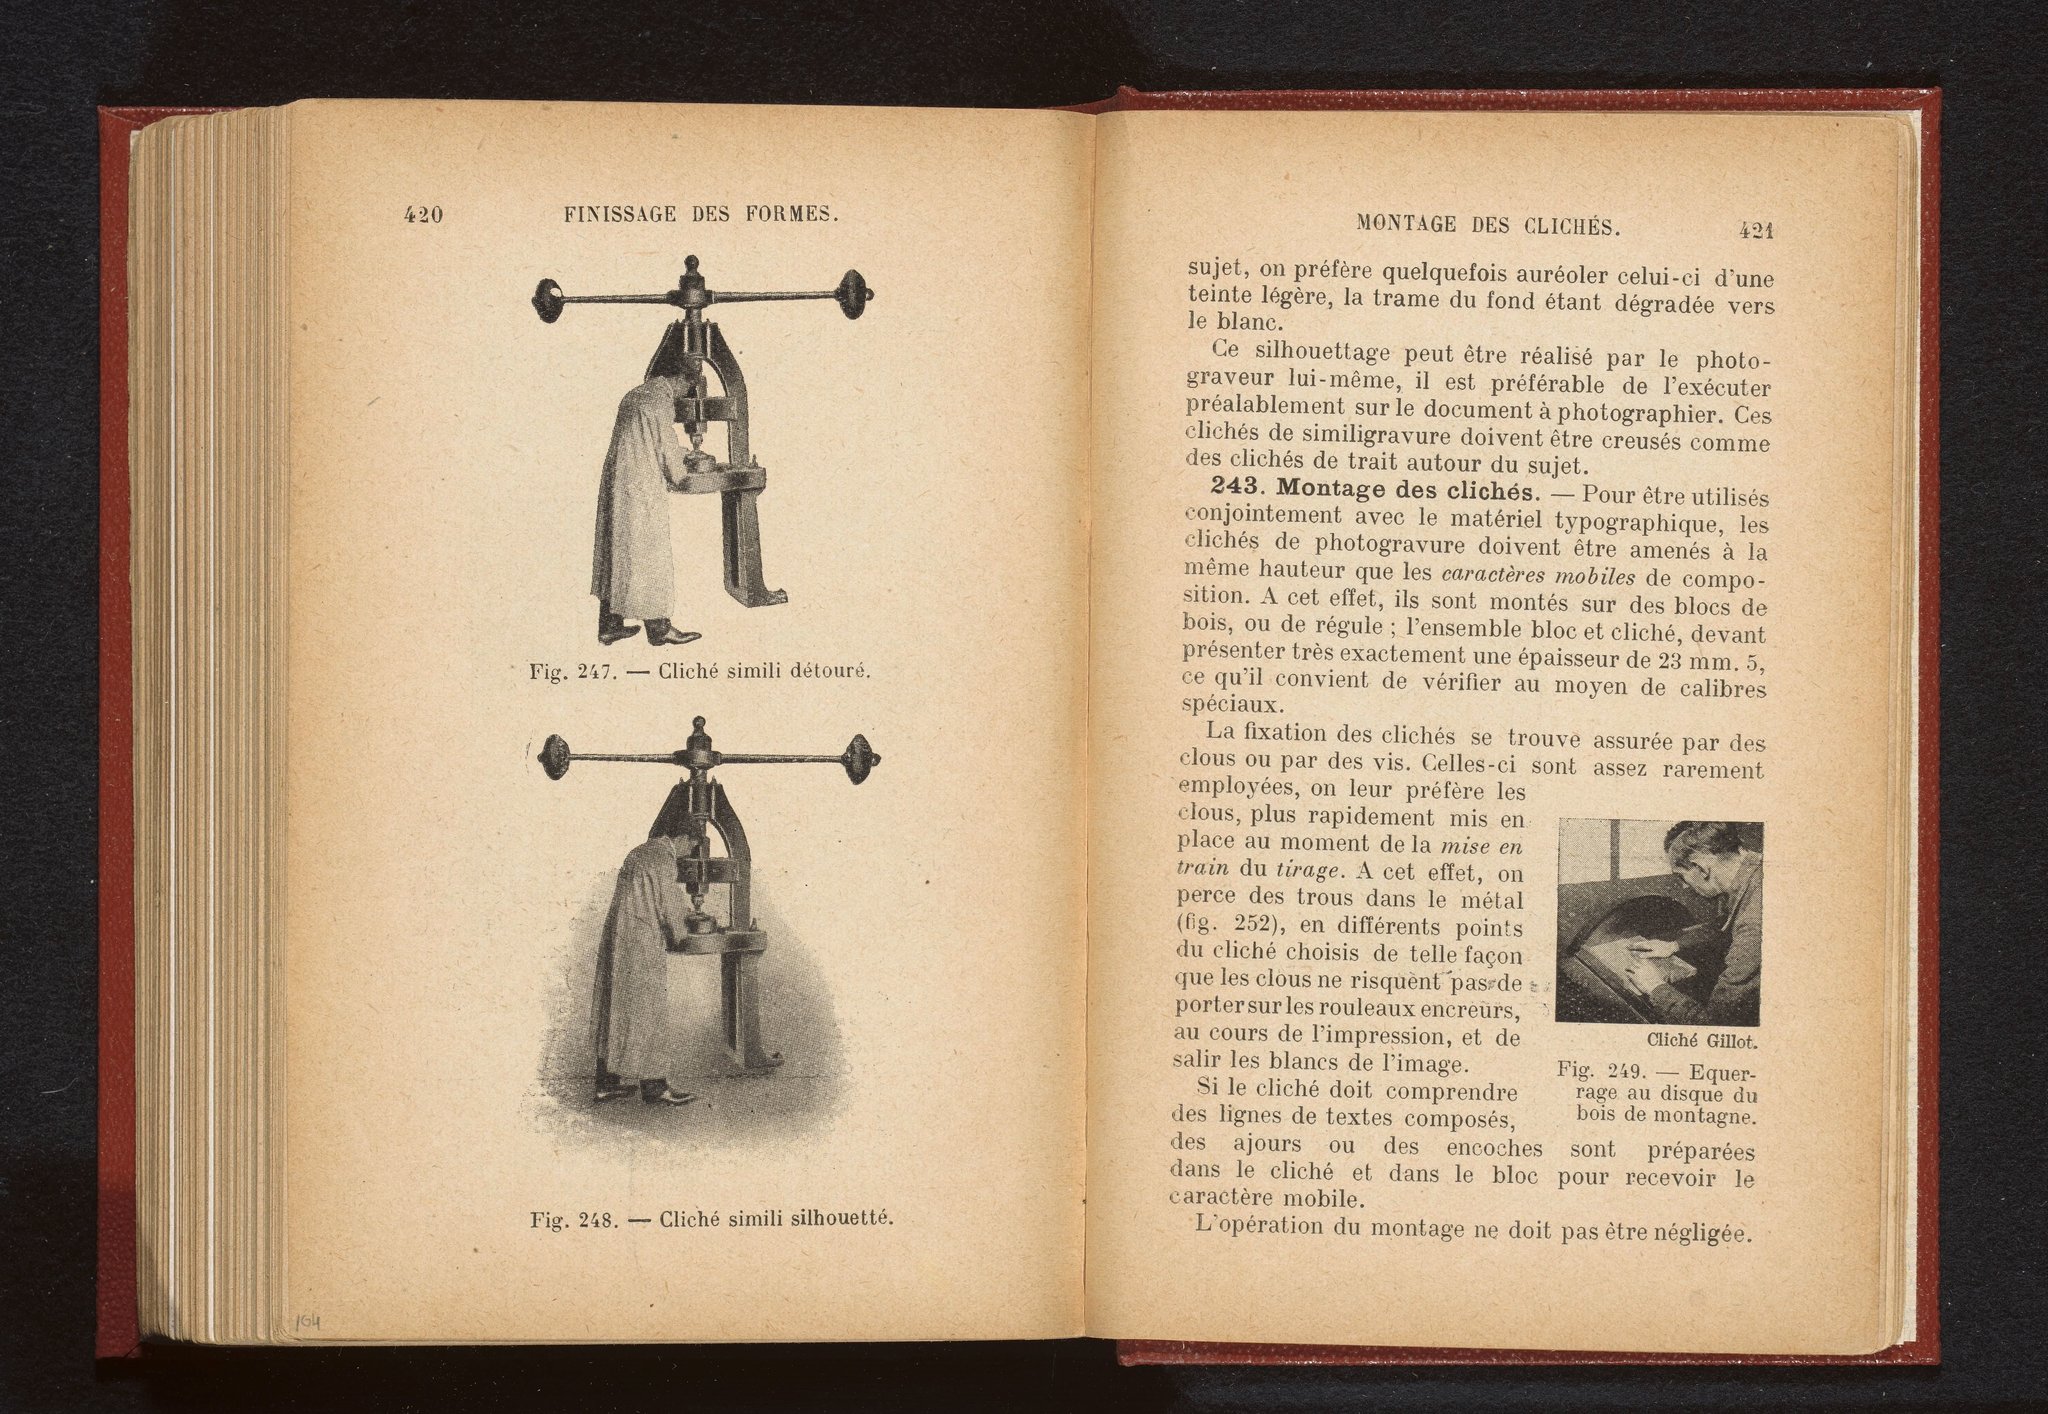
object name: page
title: Finissage des formes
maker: Anonymous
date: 1922-1932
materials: paper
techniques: autotype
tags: photographic apparatus, printing, printing office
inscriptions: inscription: ‘Cliché simili détourné. Cliché simili silhouetté’, number: ‘Fig. 248.’